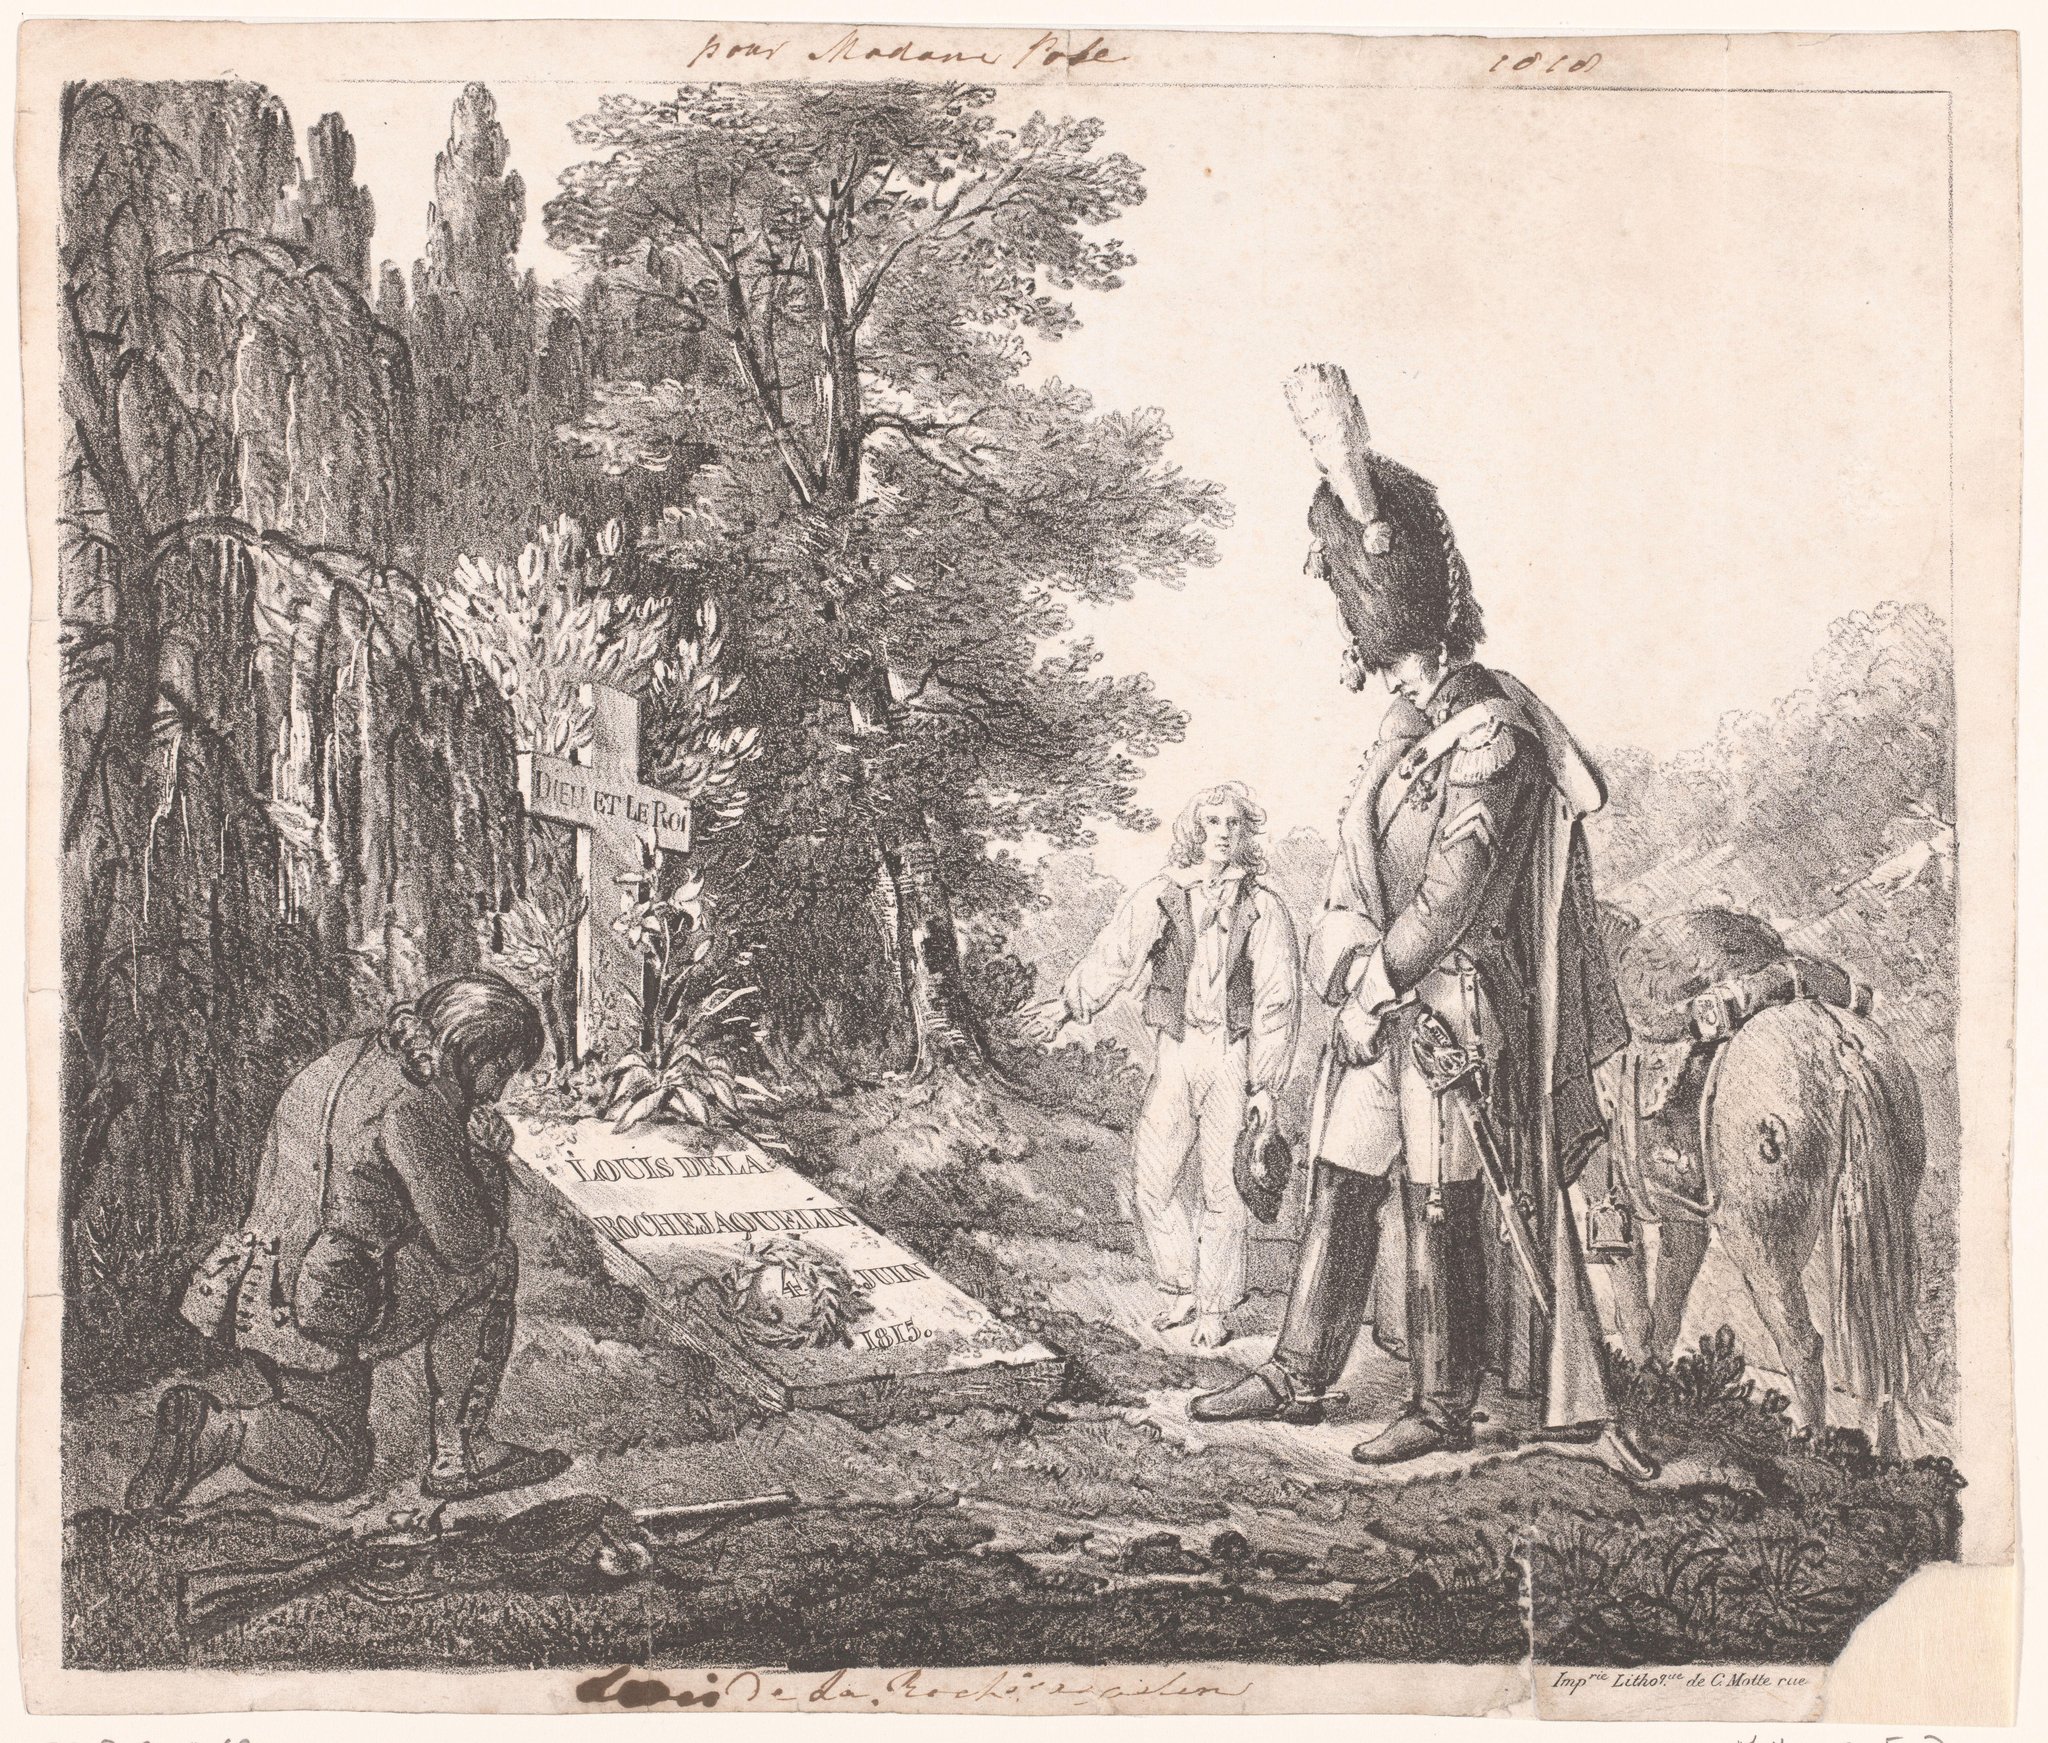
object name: ornament print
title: Vaas met bloemen en en insecten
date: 1601-1652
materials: paper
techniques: engraving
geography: amsterdam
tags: birds, flowers in a vase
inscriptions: collector's mark: 2930, collector's mark: ‘RA’ 167, collector's mark: Lugt 2228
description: Een vaas met een bos van verschillende bloemen en insecten. In de achtergrond drie vogels, waaronder een papegaai.